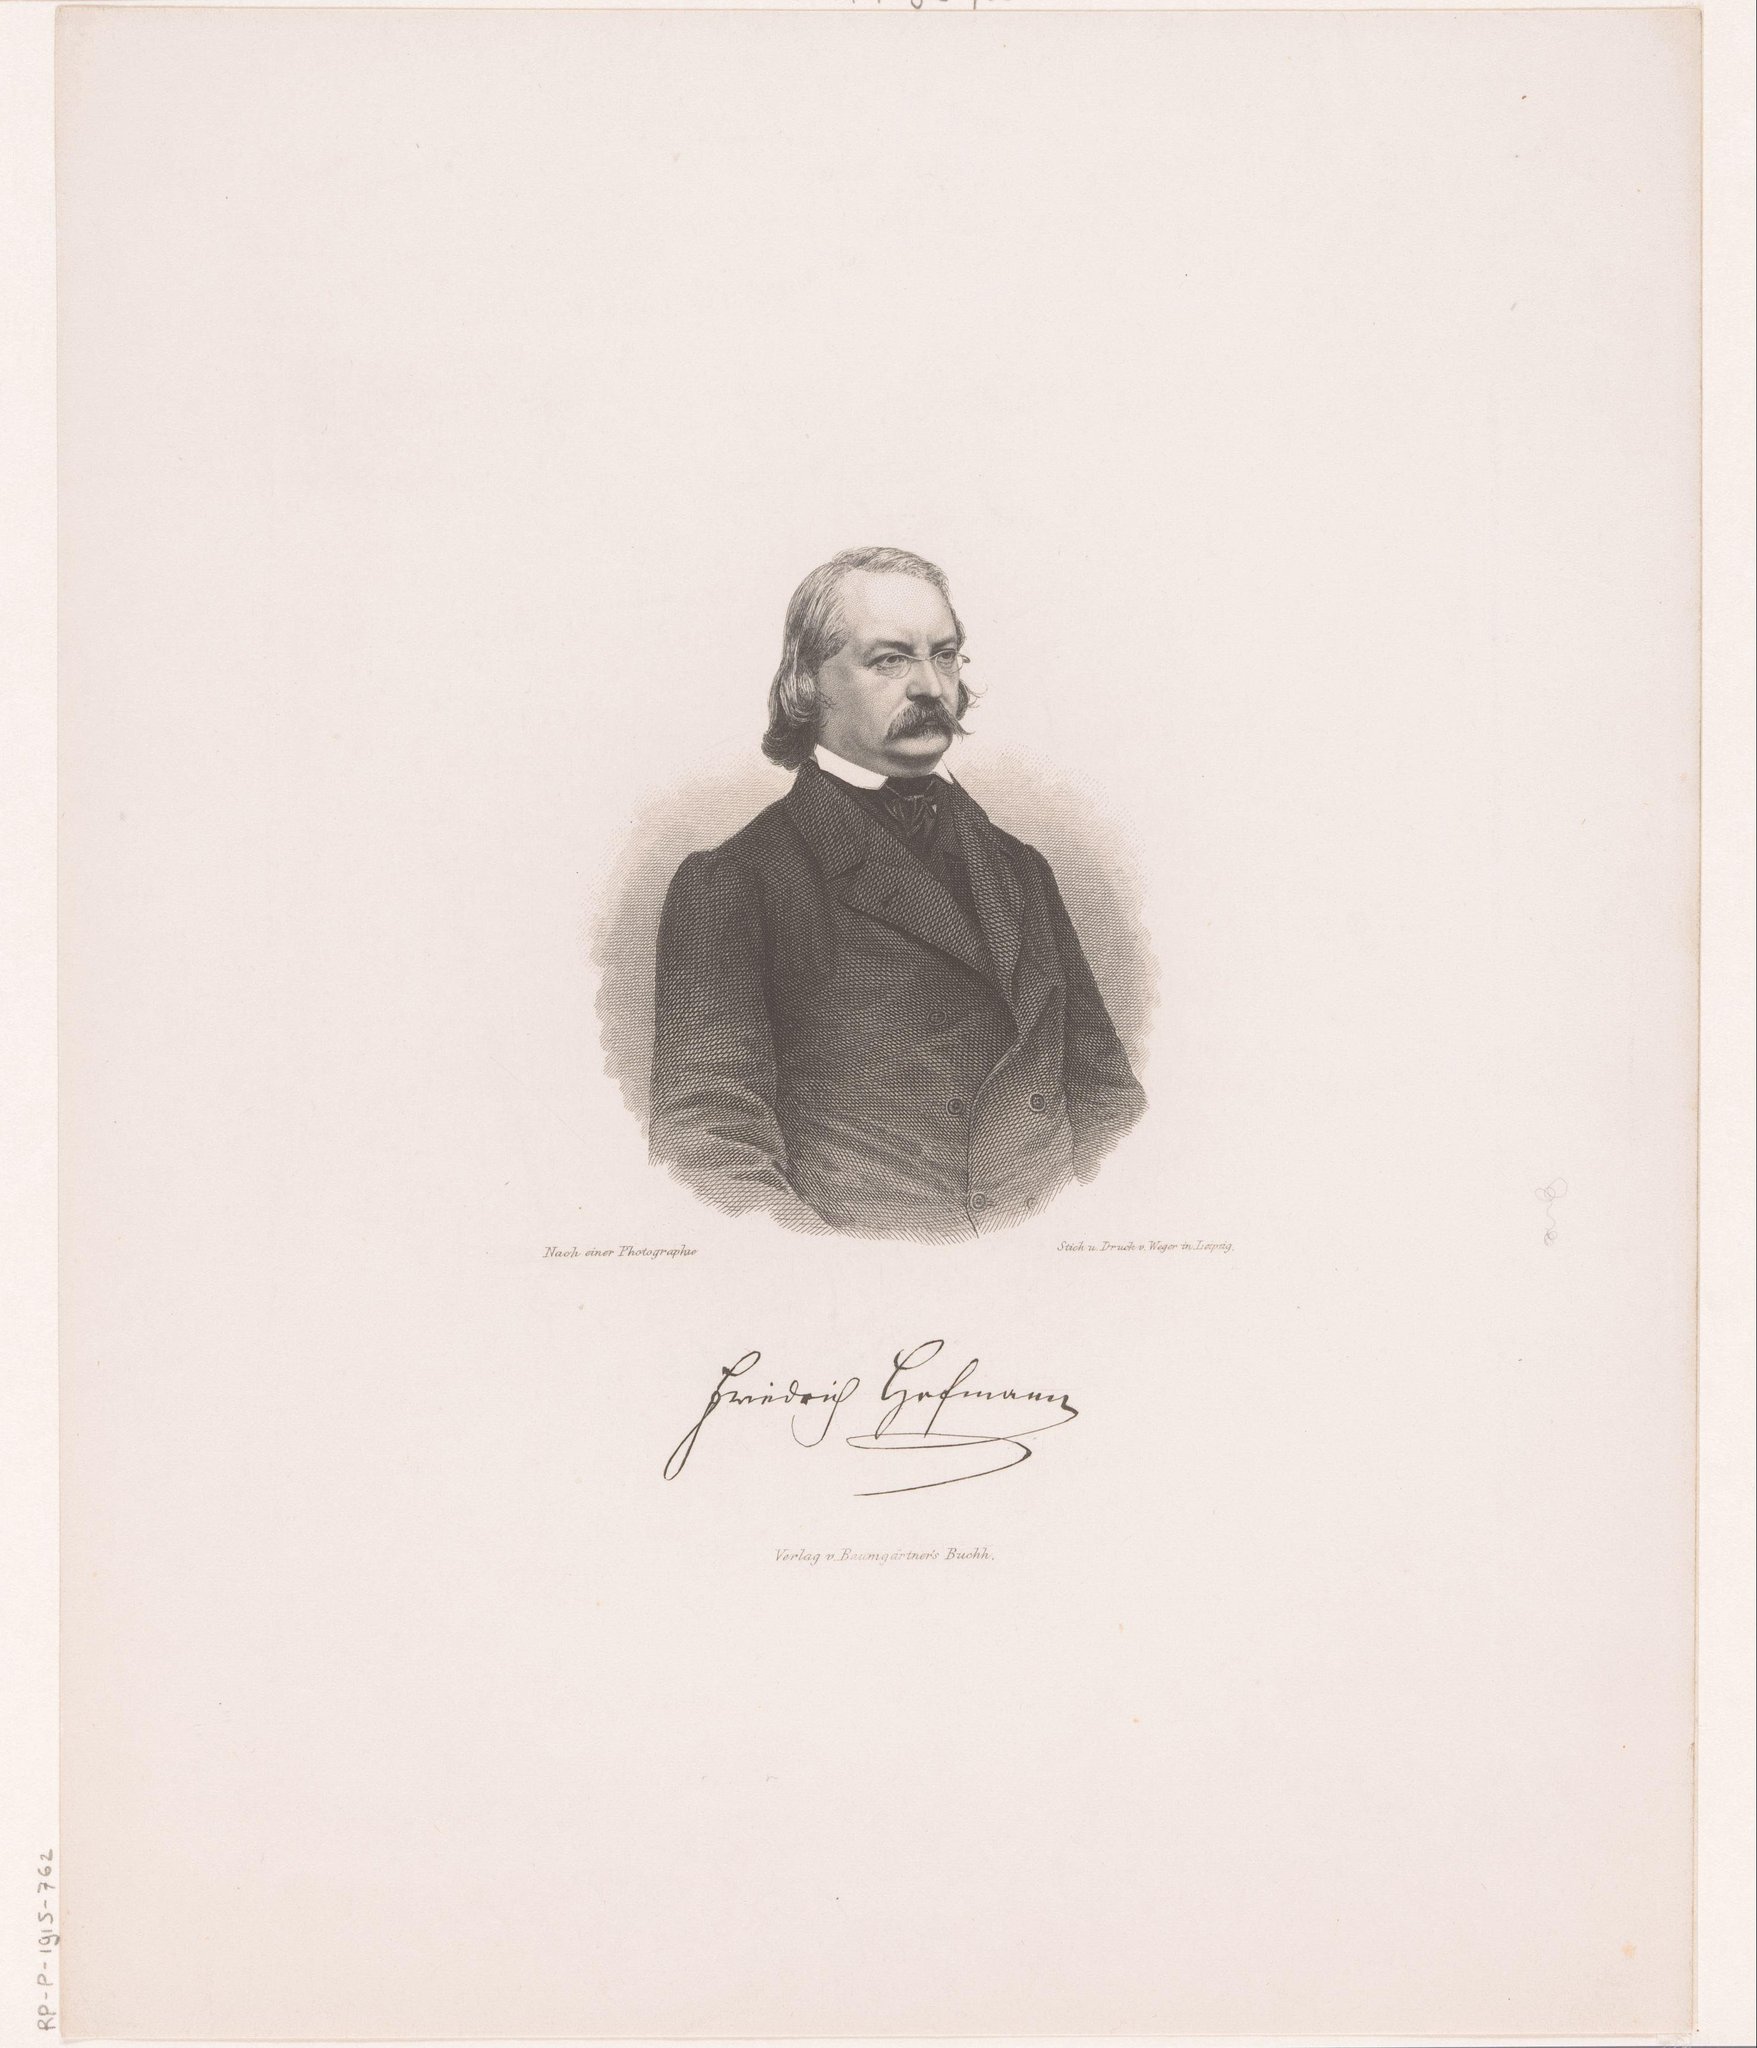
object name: print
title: Portret van Friedrich Hofmann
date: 1849-1892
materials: paper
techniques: engraving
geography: leipzig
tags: historical persons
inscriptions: collector's mark: Lugt 2228